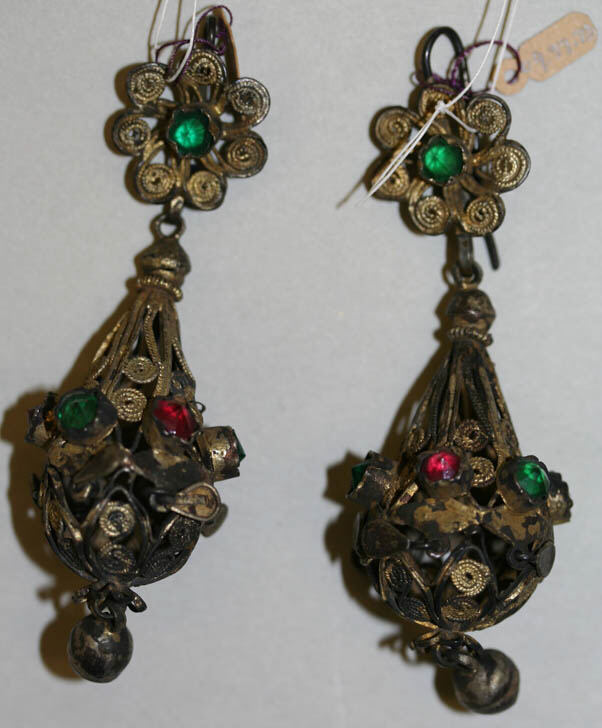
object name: earring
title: Earrings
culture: european, eastern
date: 1701-1900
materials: metal